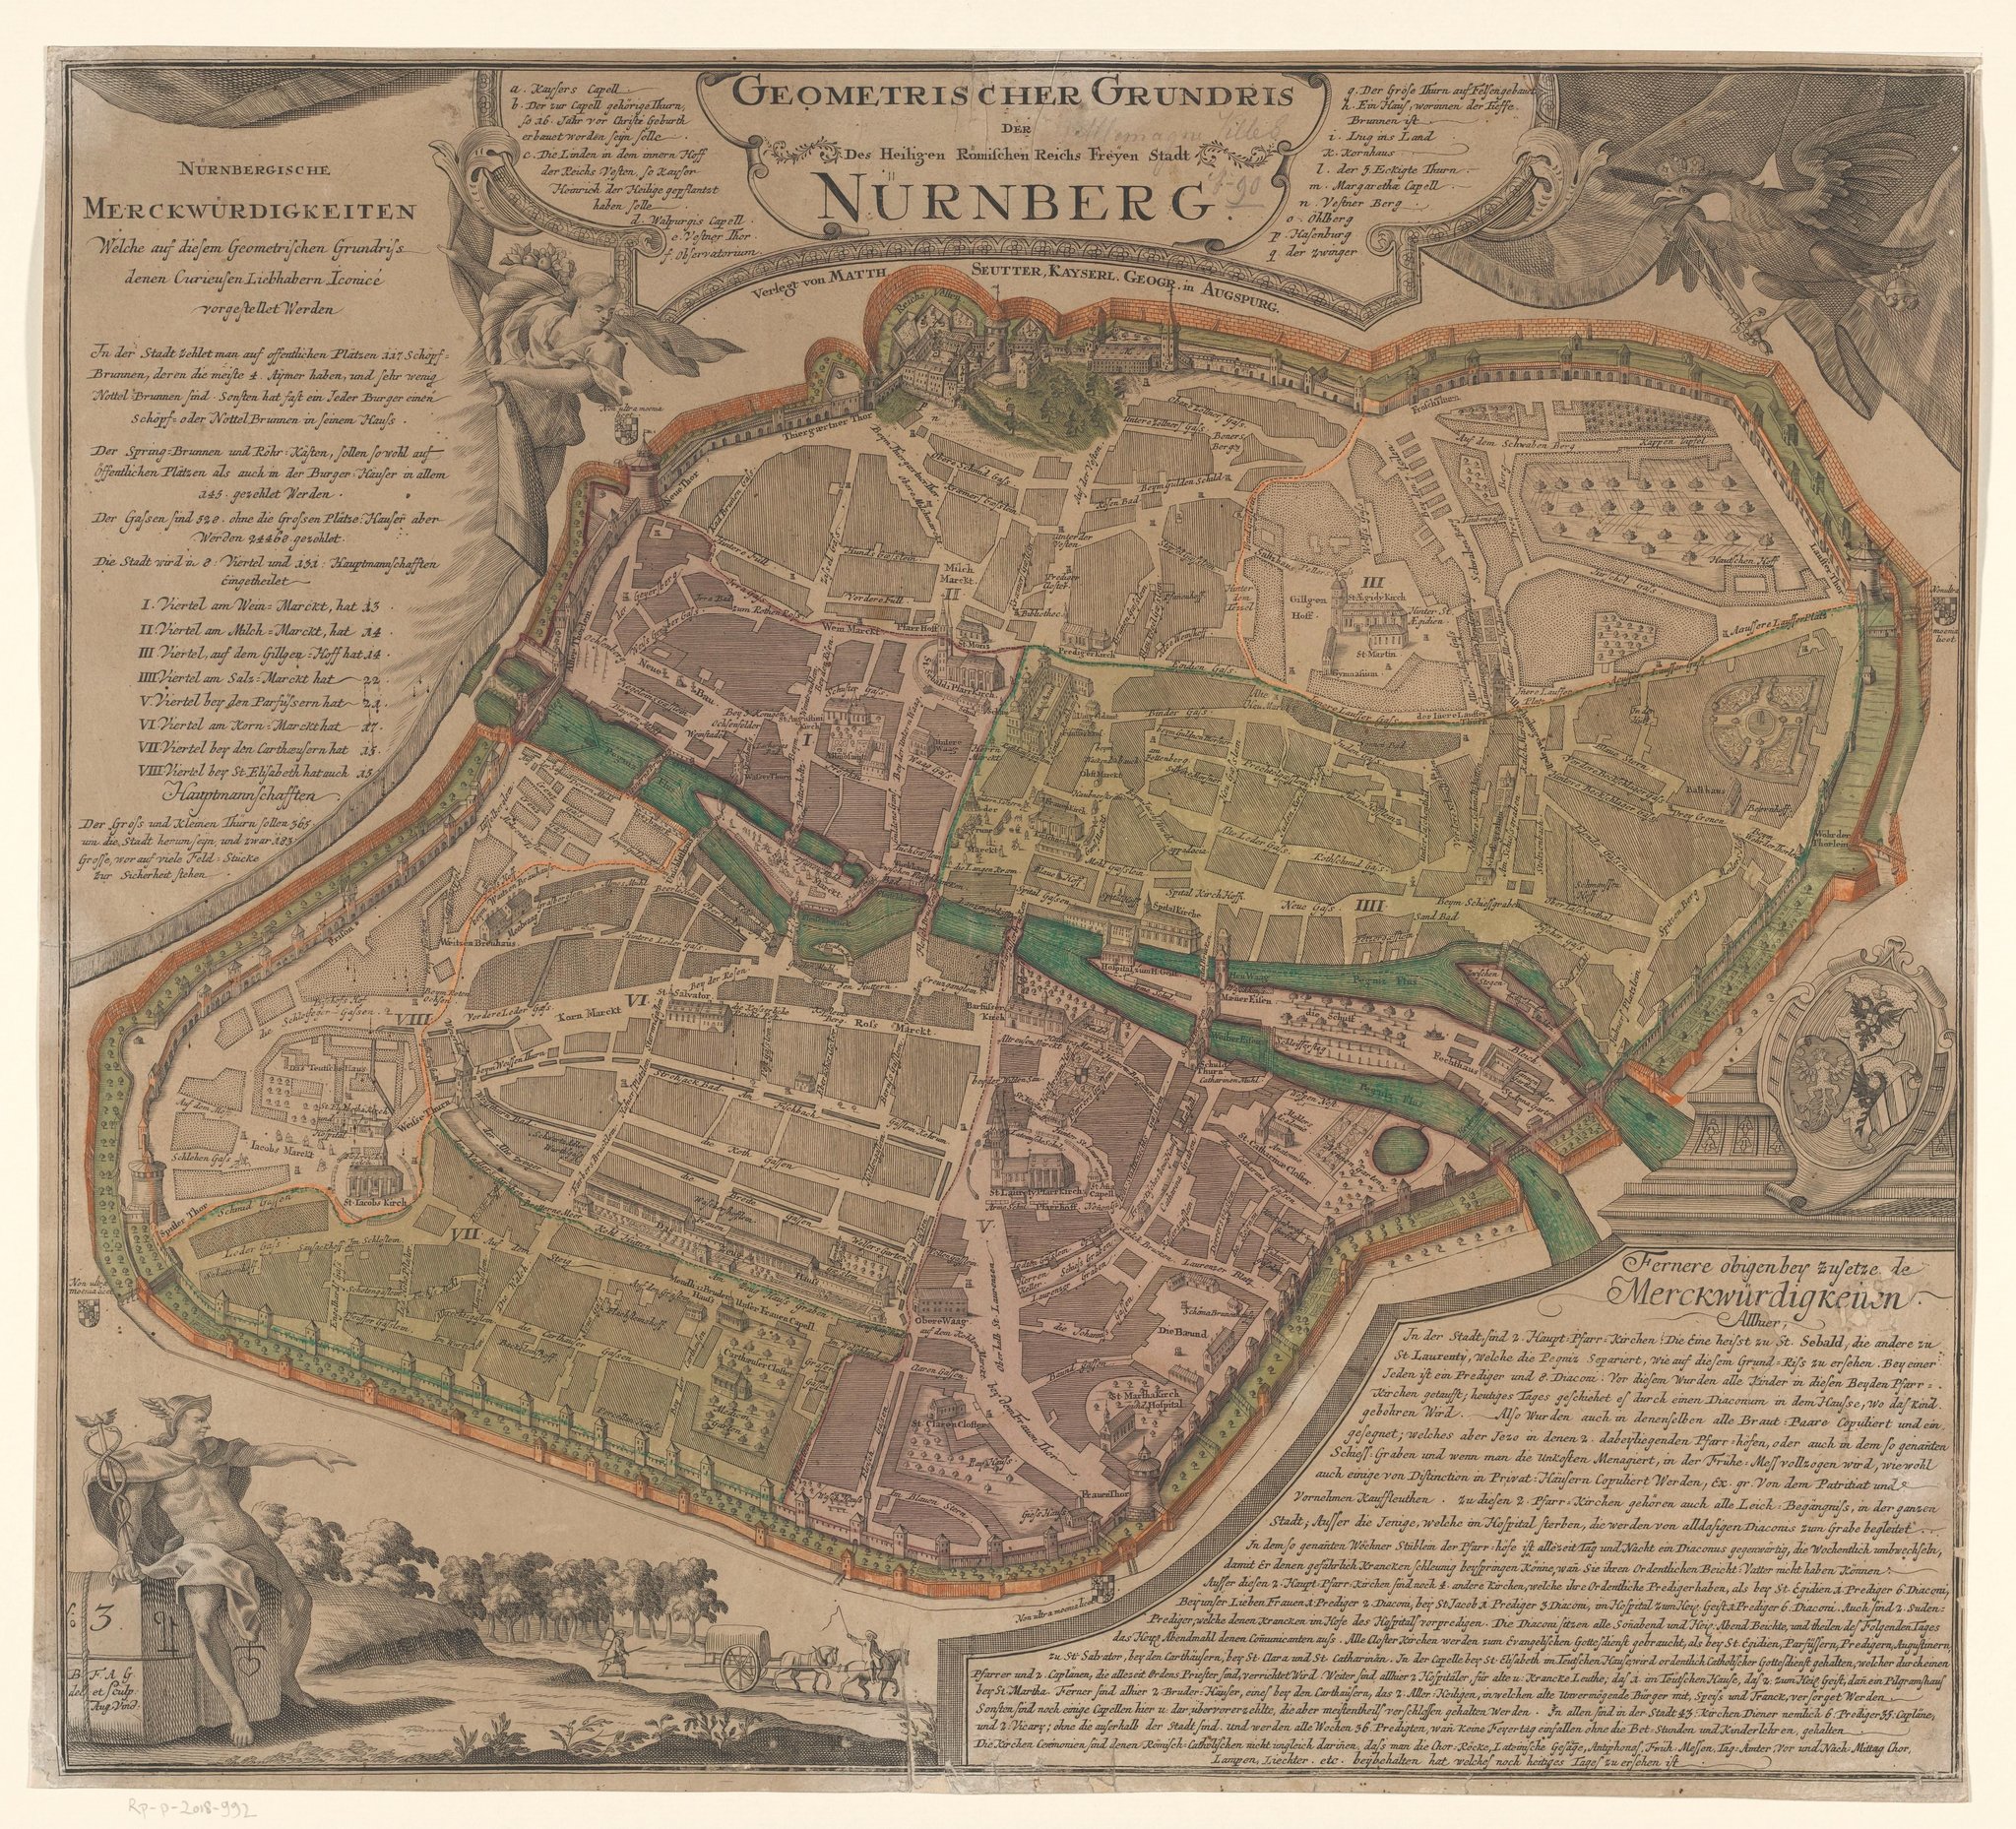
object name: area plan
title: Plattegrond van Neurenberg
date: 1707-1757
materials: paper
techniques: engraving, etching, hand coloring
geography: augsburg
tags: (story of) mercury (hermes), maps of cities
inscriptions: collector's mark: Lugt 2228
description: Plattegrond van Neurenberg, met de voornaamste gebouwen in vogelvluchtperspectief.